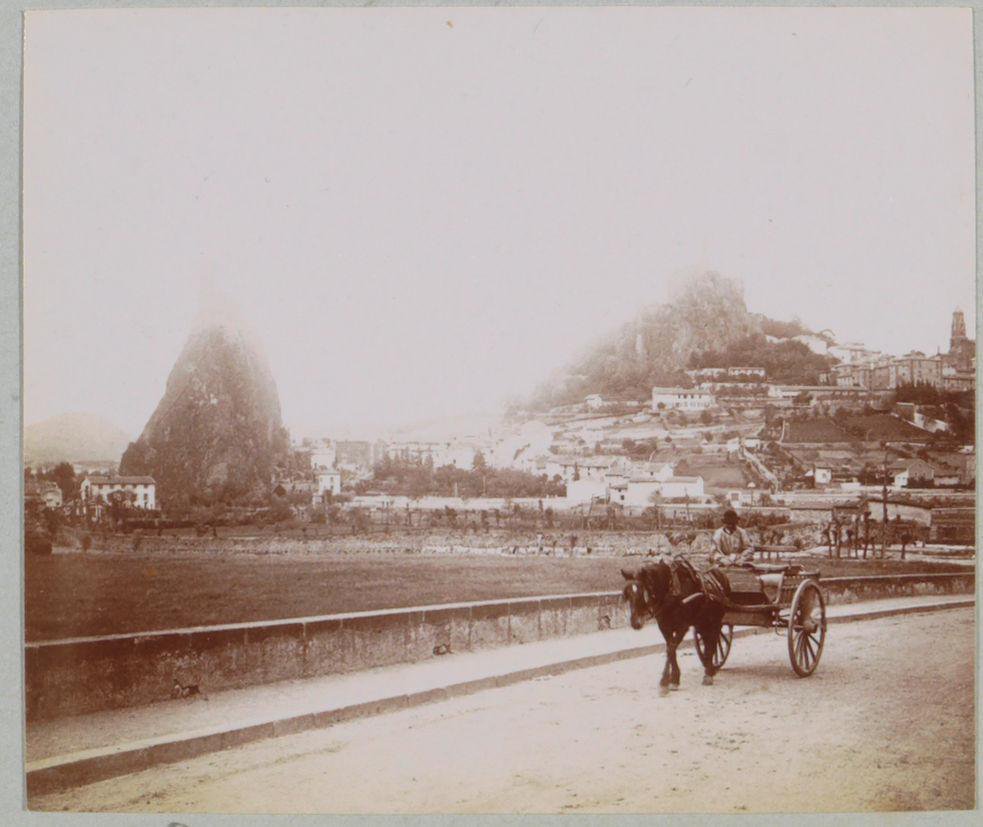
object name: photograph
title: Gezicht op rotsformaties in Le Puy-en-Velay met op de voorgrond een paardenkar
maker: delizy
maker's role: manufacturer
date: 1902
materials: paper, photographic support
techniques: gelatin silver print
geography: le puy-en-velay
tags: prospect of village, silhouette of village, two-wheeled, animal-drawn vehicle, rock-formations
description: Onderdeel van Fotoalbum van een Franse amateurfotograaf met opnames van uitstapjes in Frankrijk, Spanje, België, Luxemburg en Nederland, de eerste automobielen en autoraces.